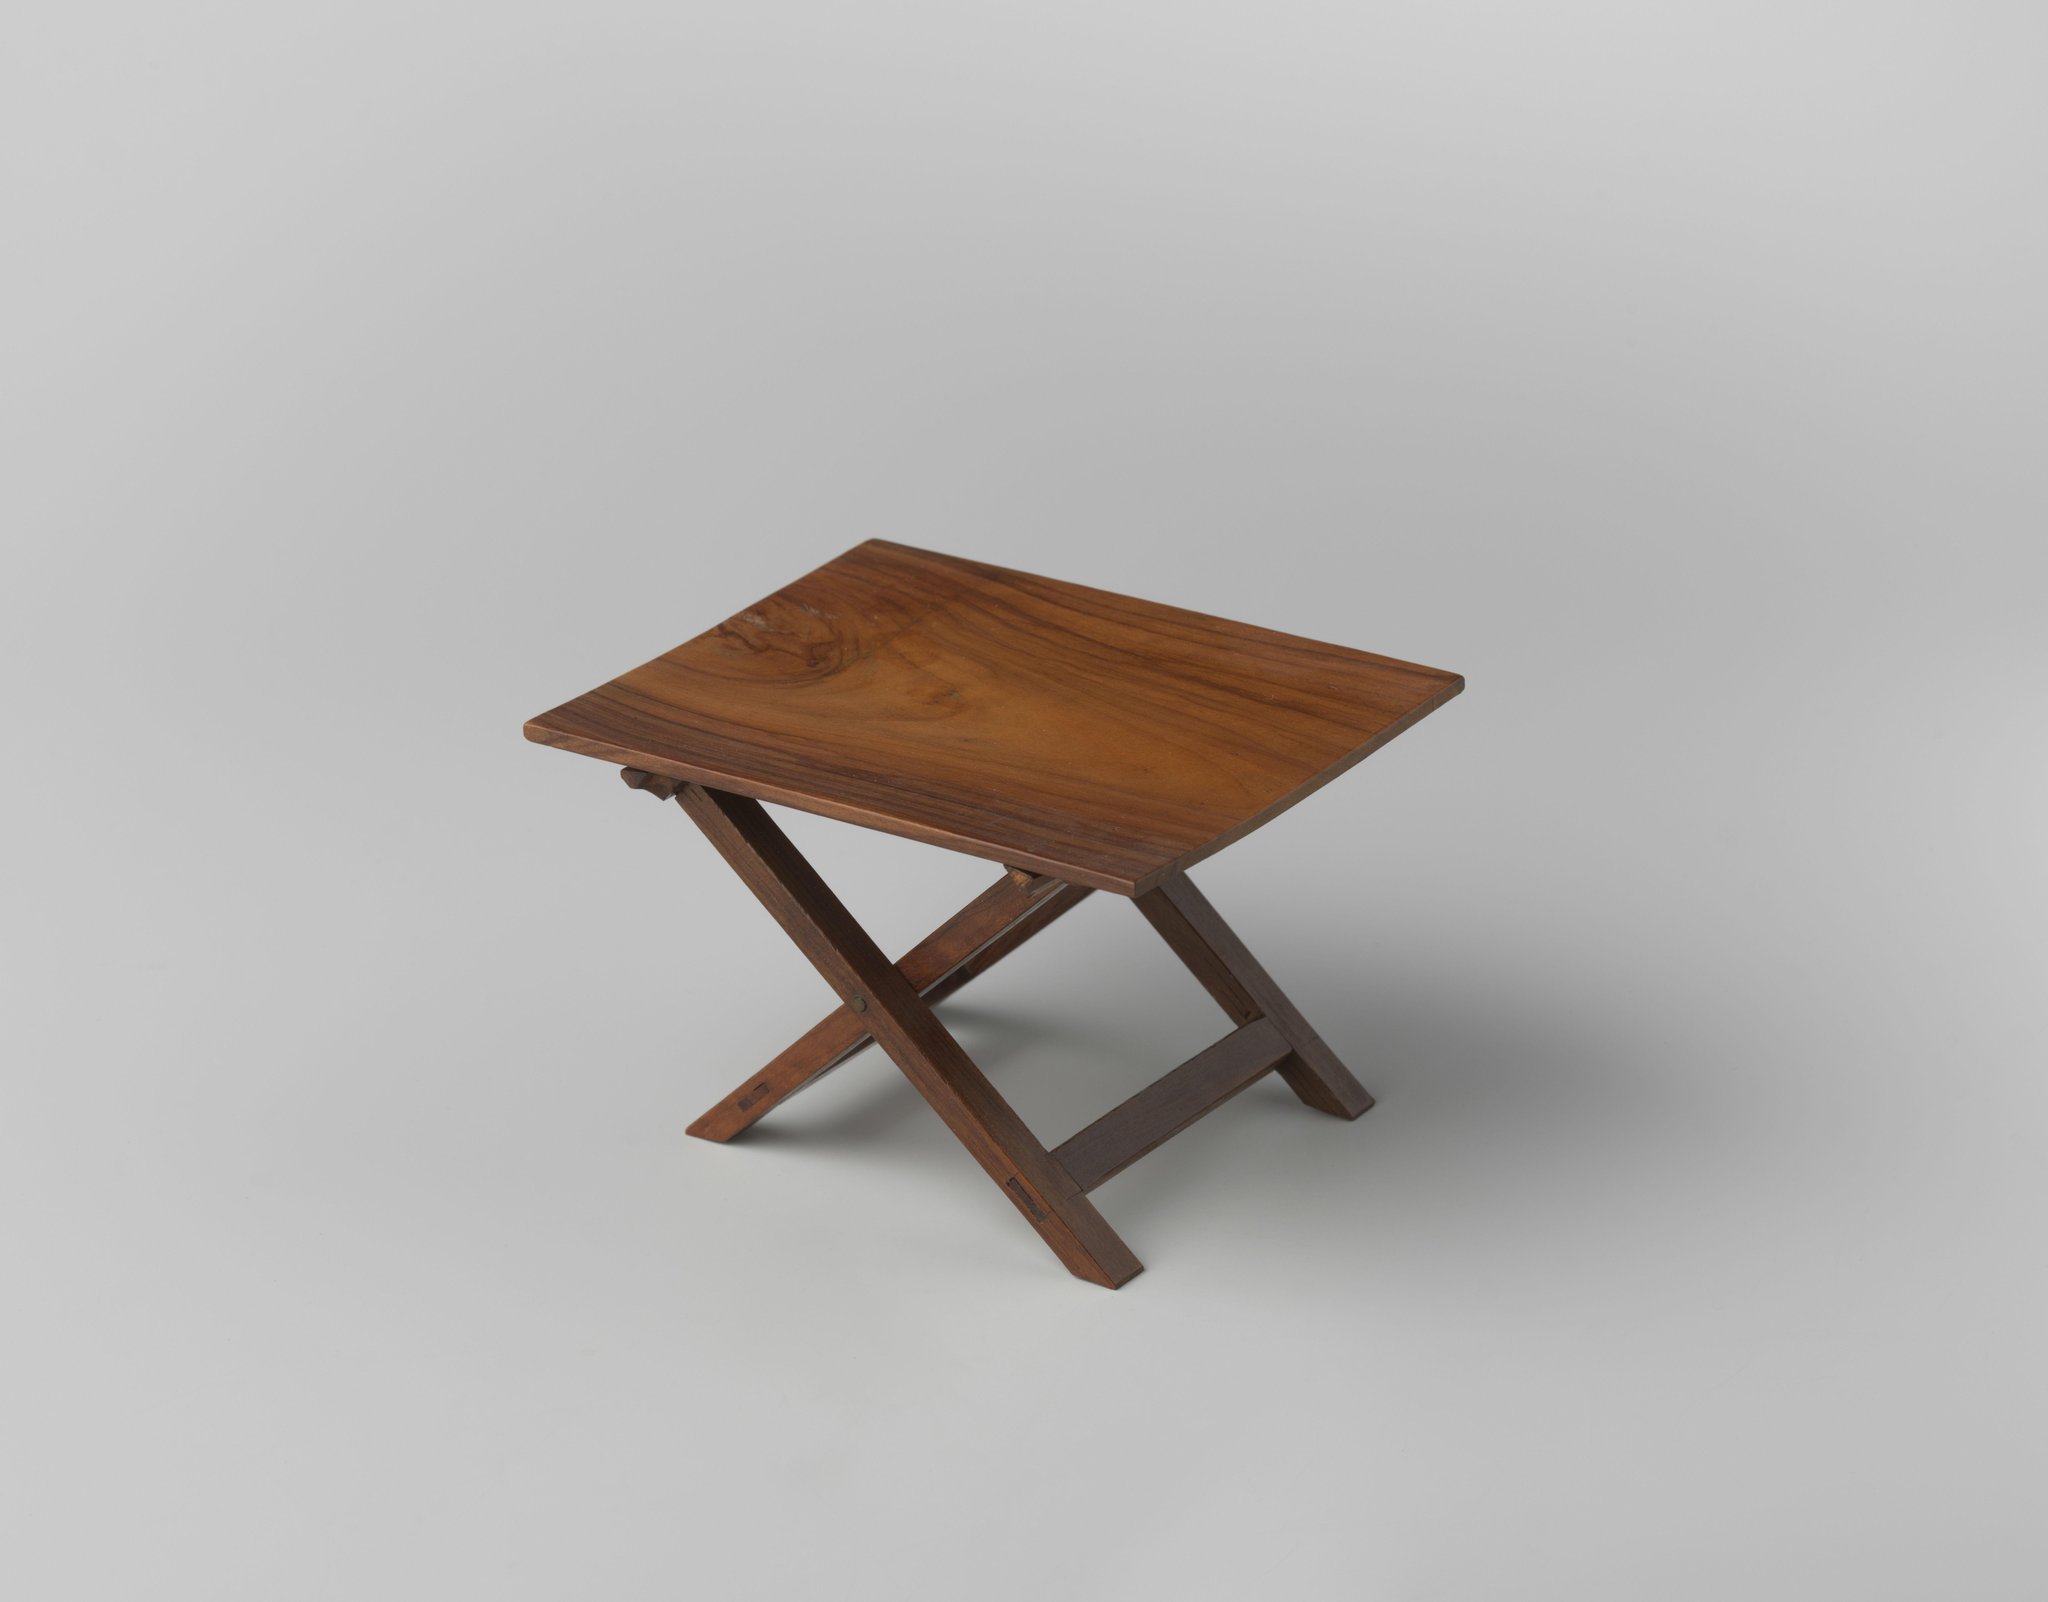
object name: miniature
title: Tafel vervaardigd van olijfhout, bestaande uit een rechthoekig los blad en een X-vormig samenklapbaar onderstel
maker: Anonymous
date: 1690-1710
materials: wood, silk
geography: amsterdam